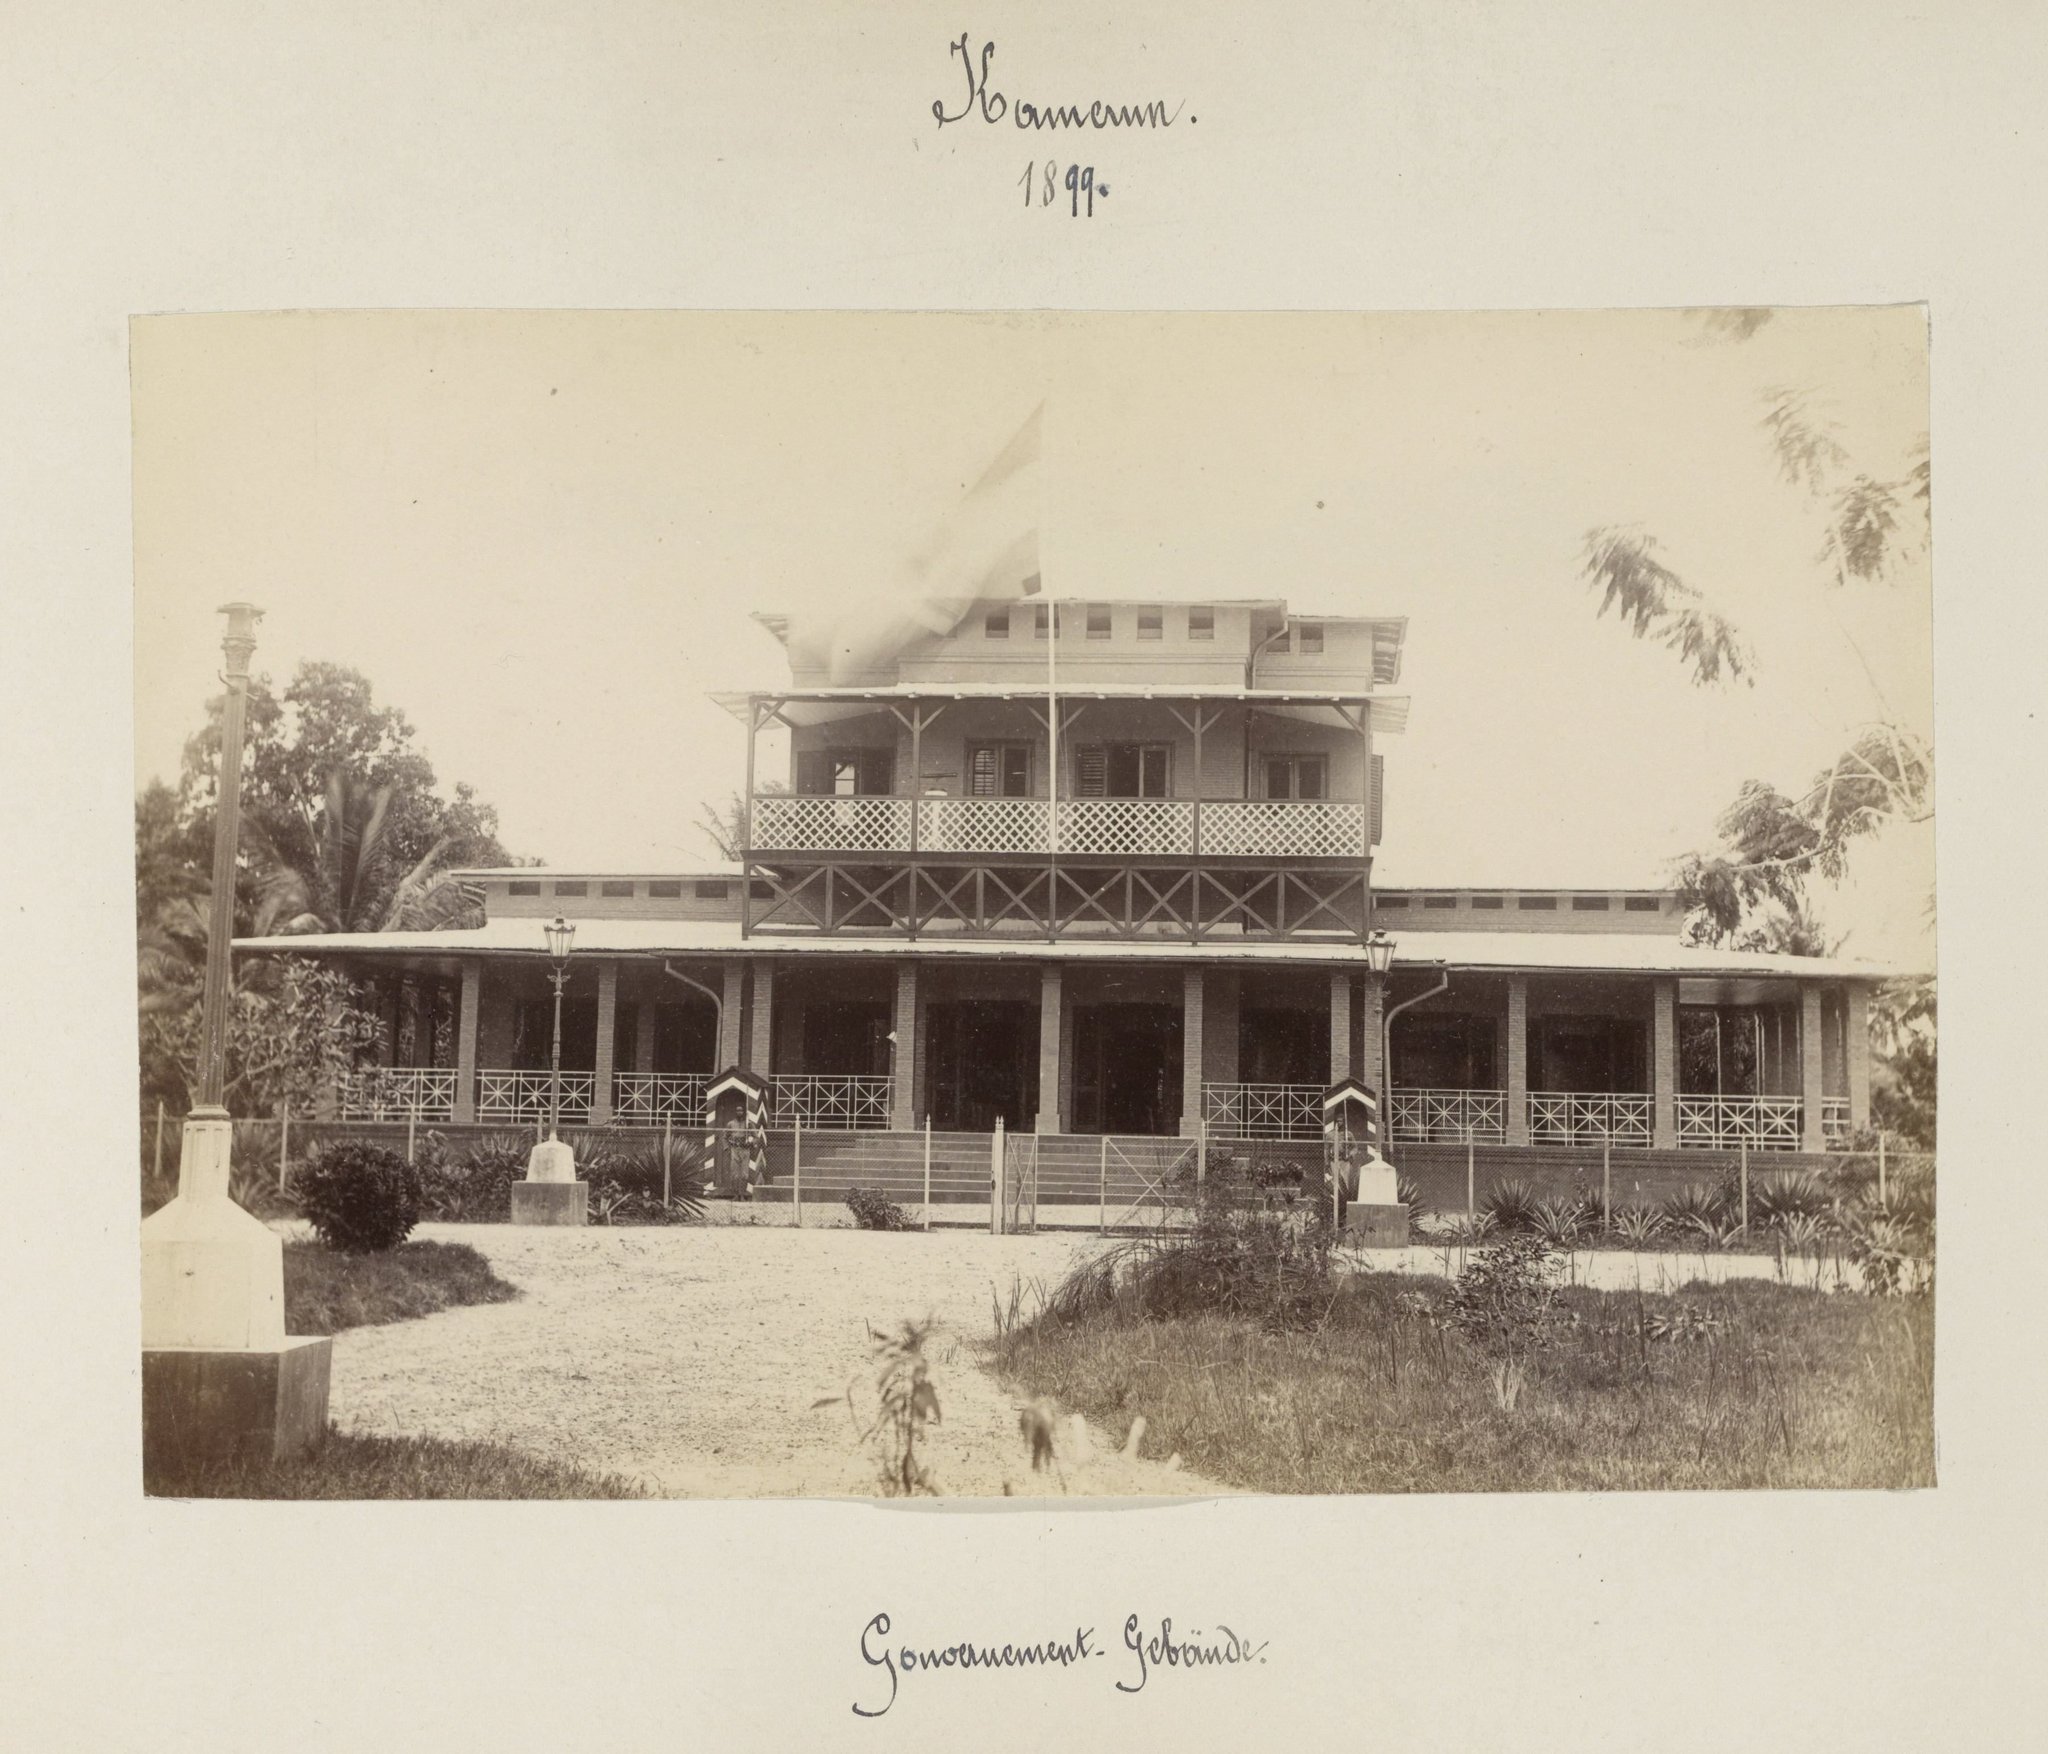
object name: photograph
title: Exterieur van een gouvernementsgebouw in Kameroen, vooraanzicht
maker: Anonymous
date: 1899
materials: photographic support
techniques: albumen print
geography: cameroon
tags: flags flown from a mast, exterior ~ representation of a building, colonial government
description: Onderdeel van Fotoalbum met opnames van Kameroen rond 1899.